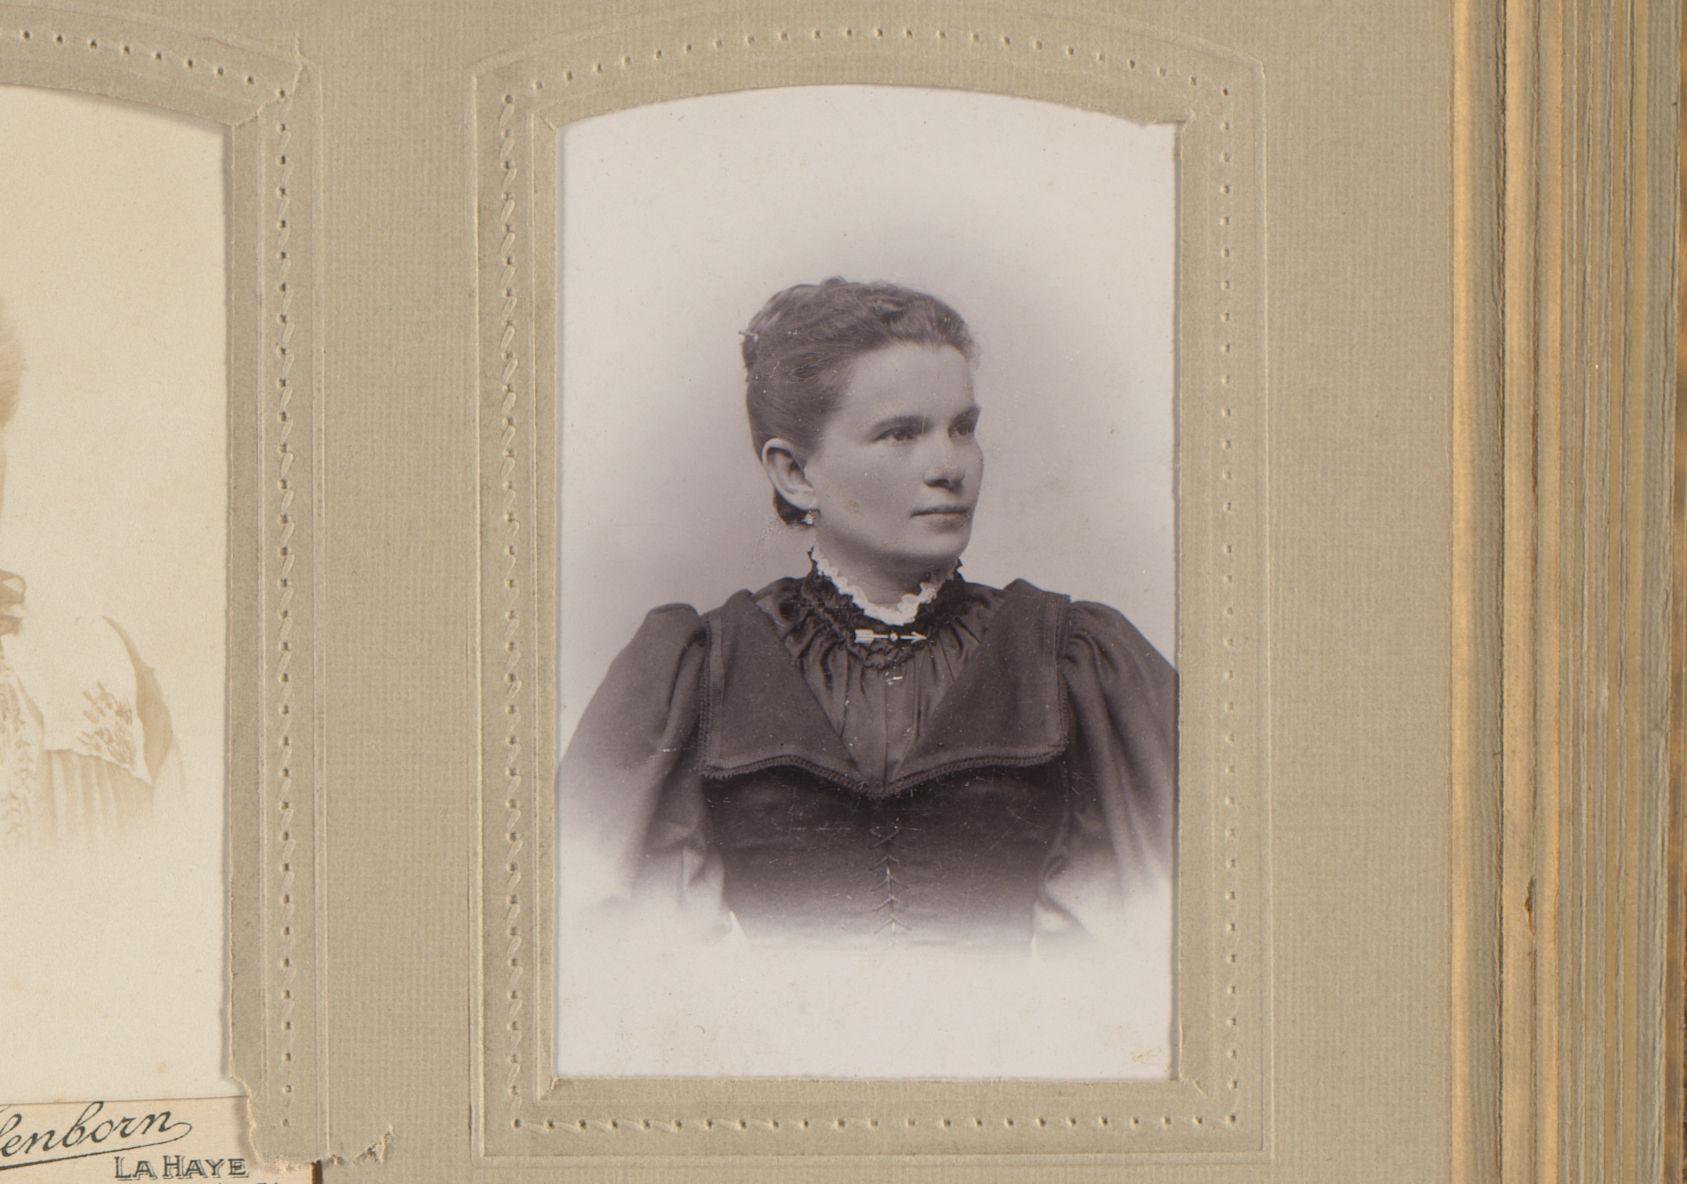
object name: photograph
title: Studioportret van Margo J.J. Kessler-de Lange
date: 1893-1895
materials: paper, photographic support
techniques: collodion silver print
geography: netherlands